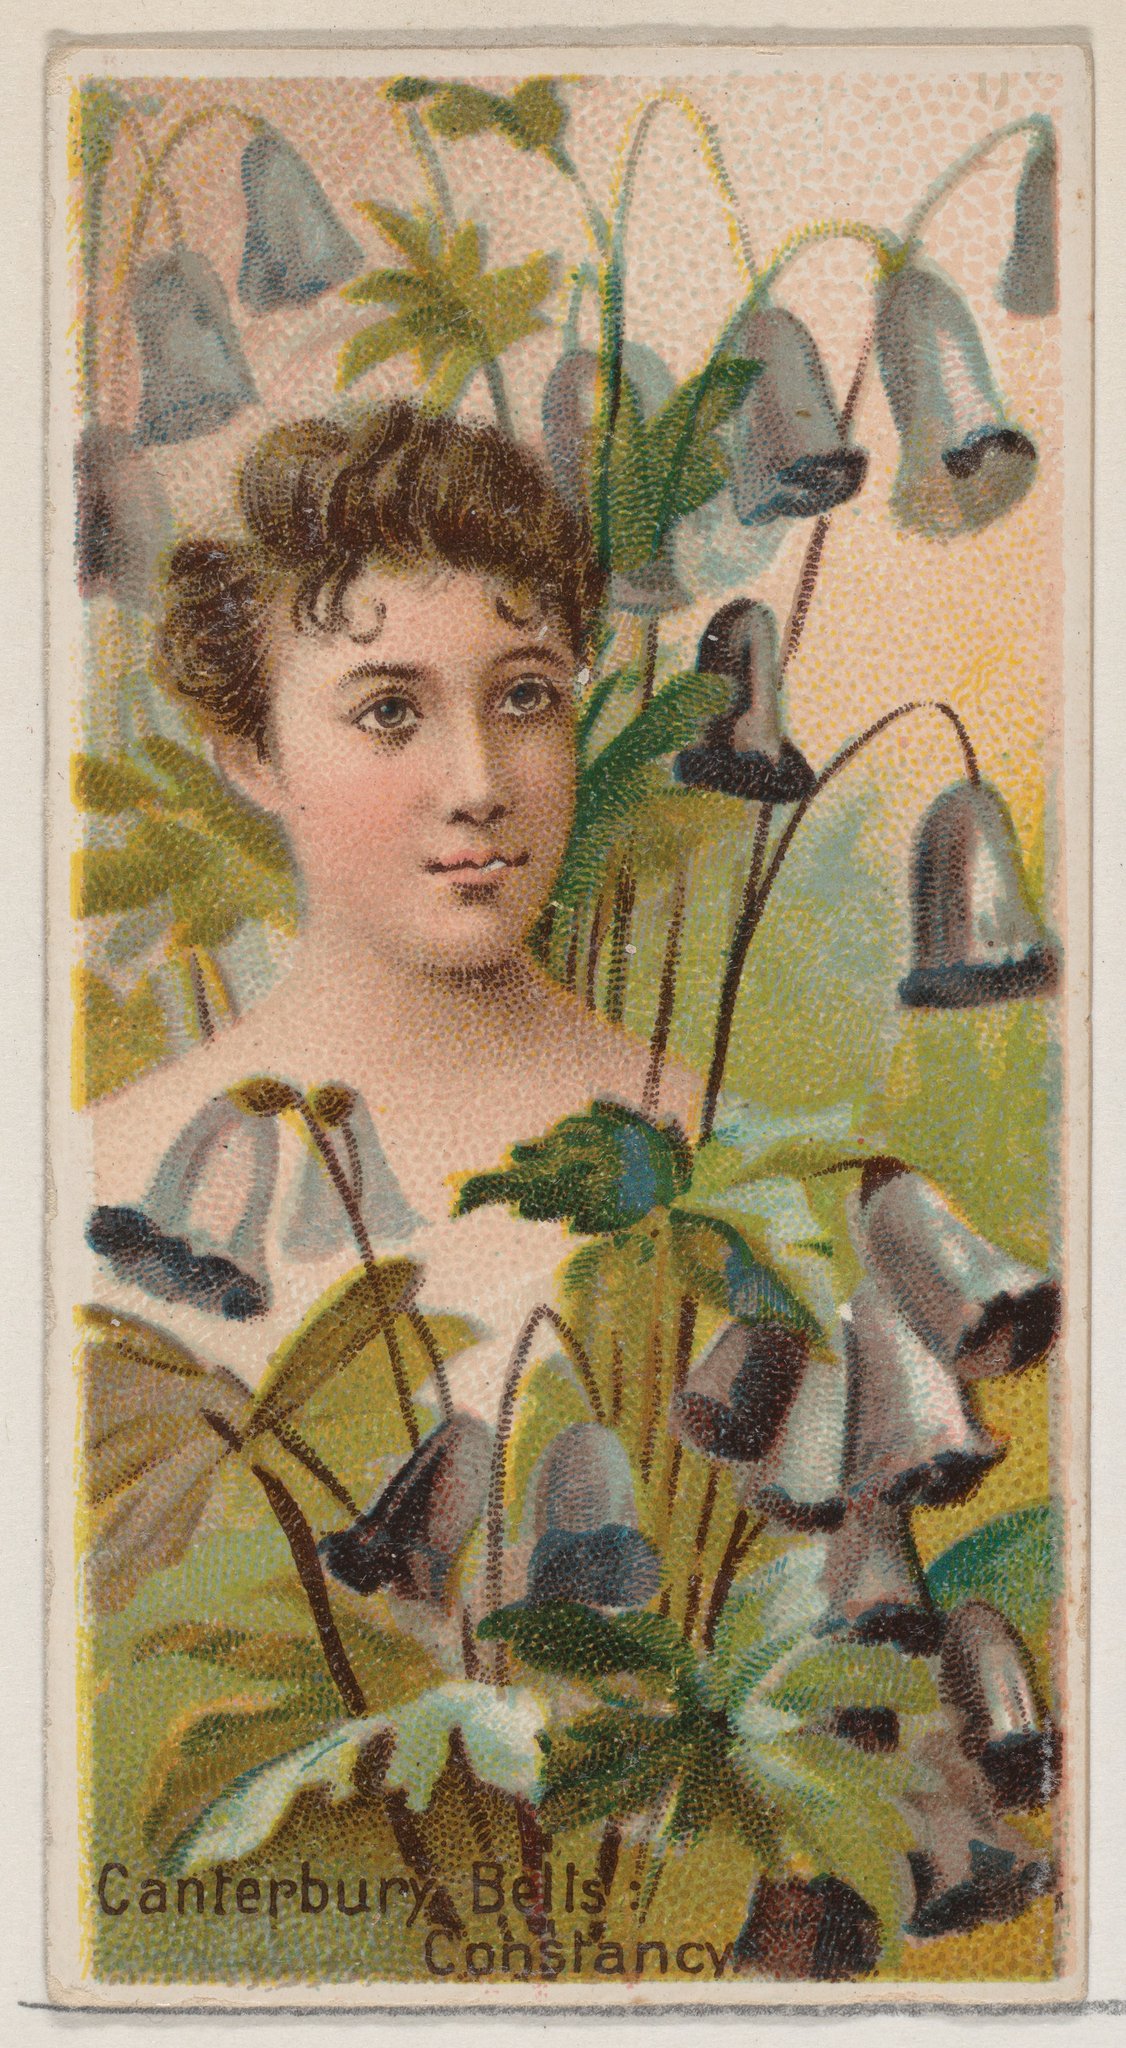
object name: print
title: Canterbury Bells: Constancy, from the series Floral Beauties and Language of Flowers (N75) for Duke brand cigarettes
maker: american tobacco company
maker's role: publisher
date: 1892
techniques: color lithograph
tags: women,flowers